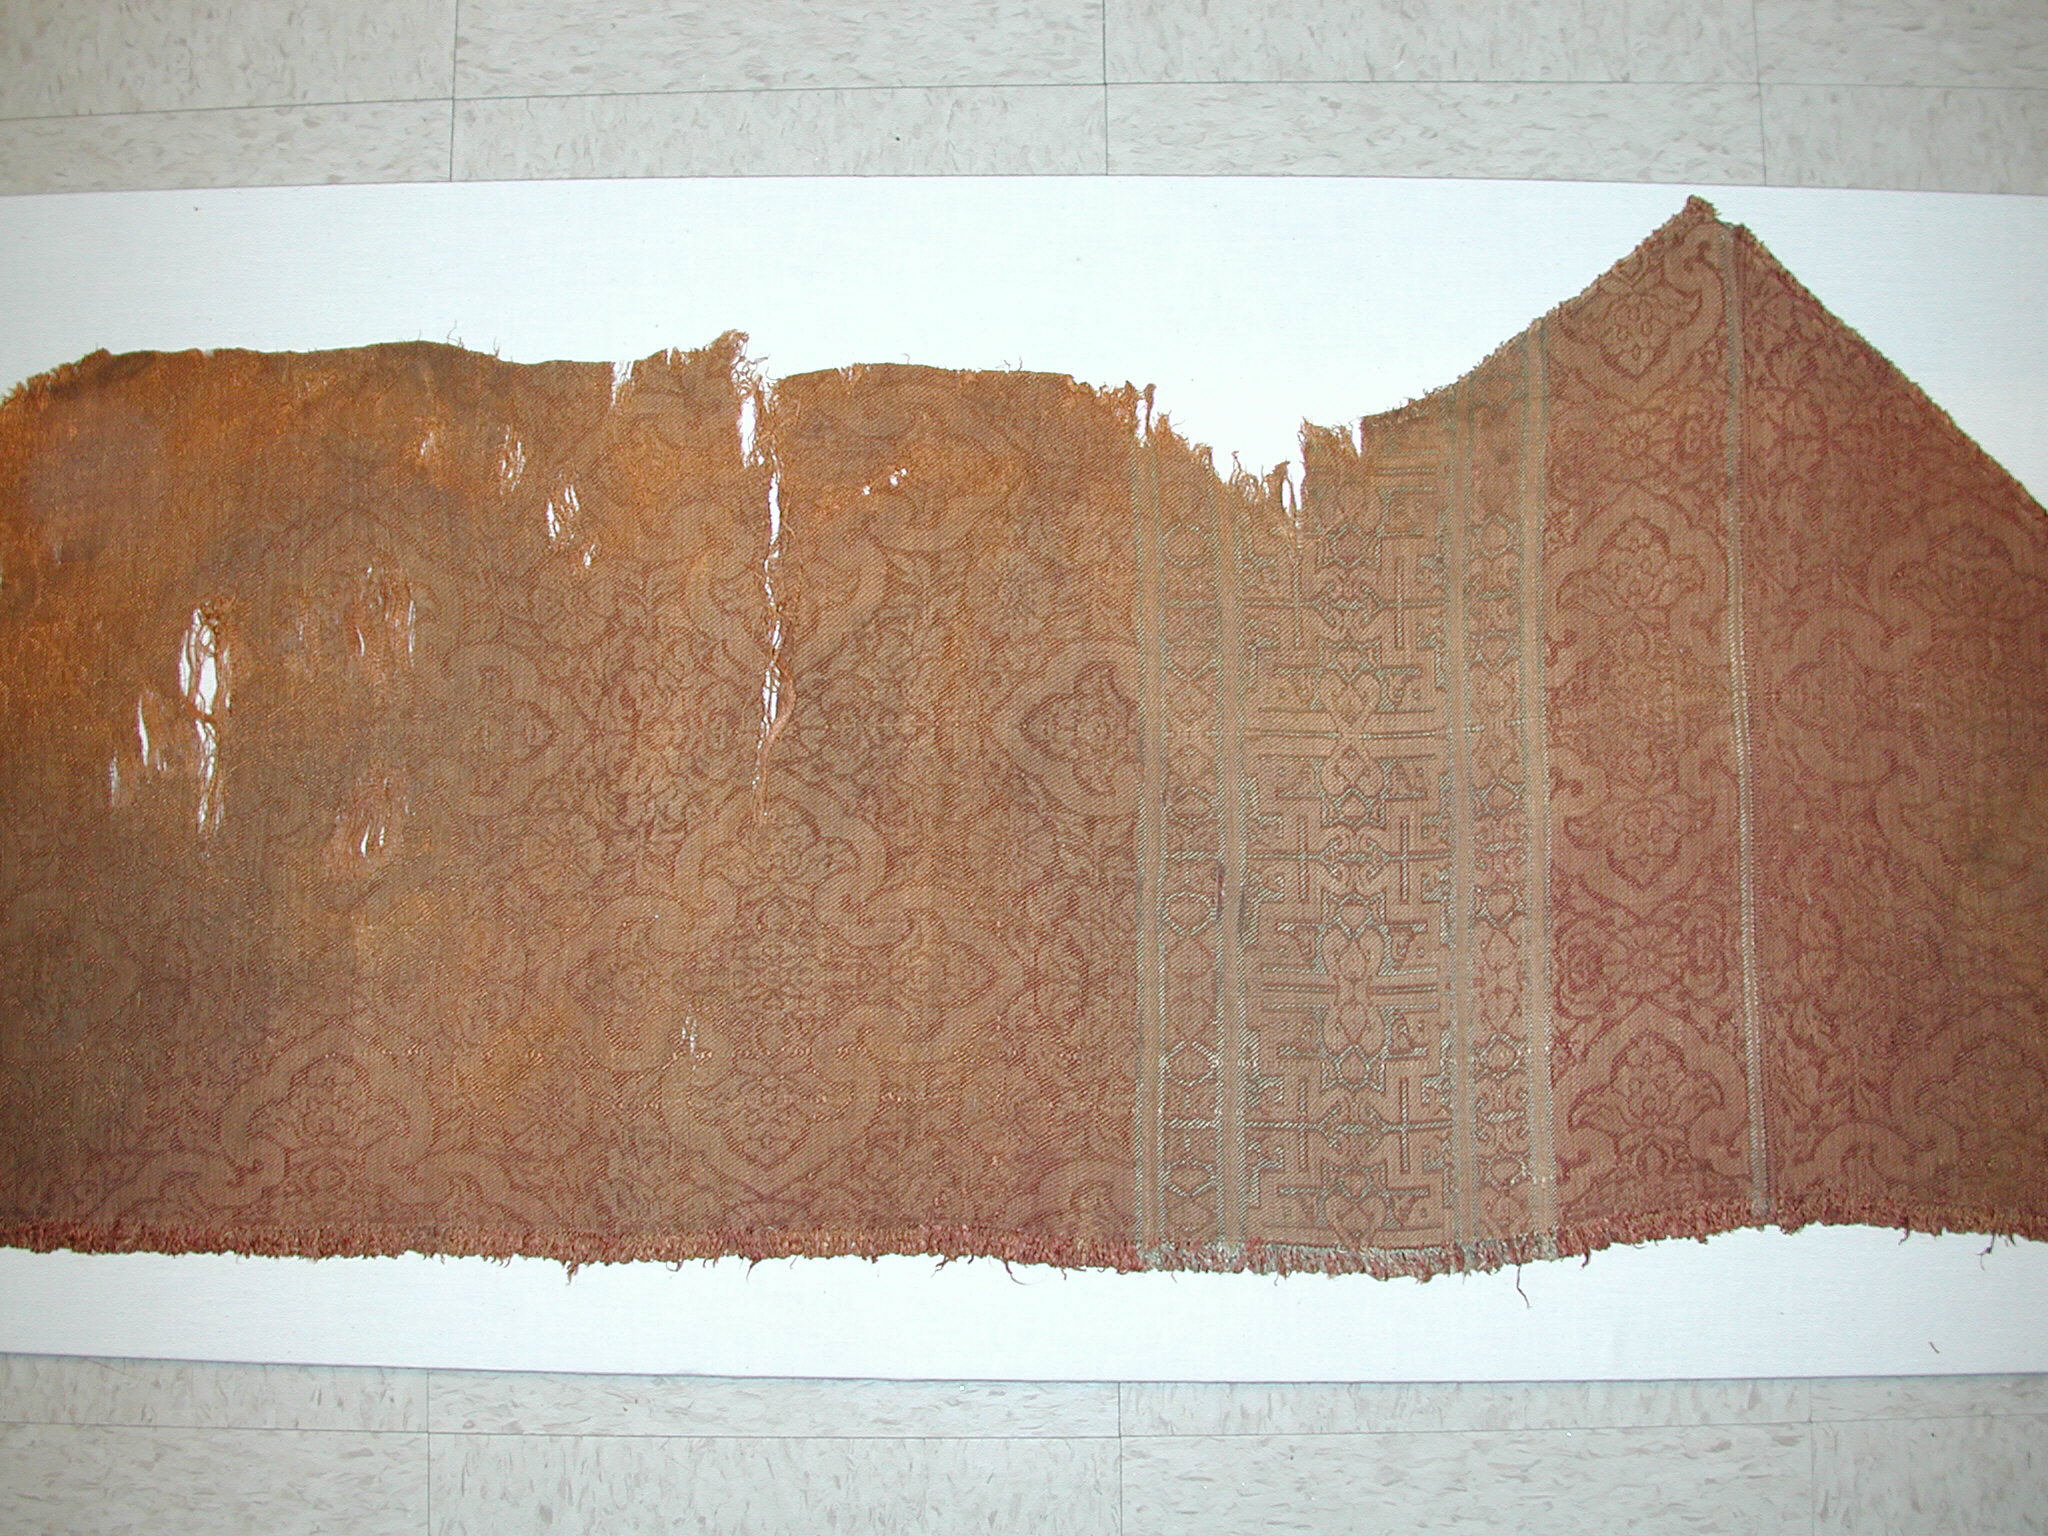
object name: textile fragment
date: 1201-1400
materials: gilt, metal thread, silk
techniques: weave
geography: islamic lands